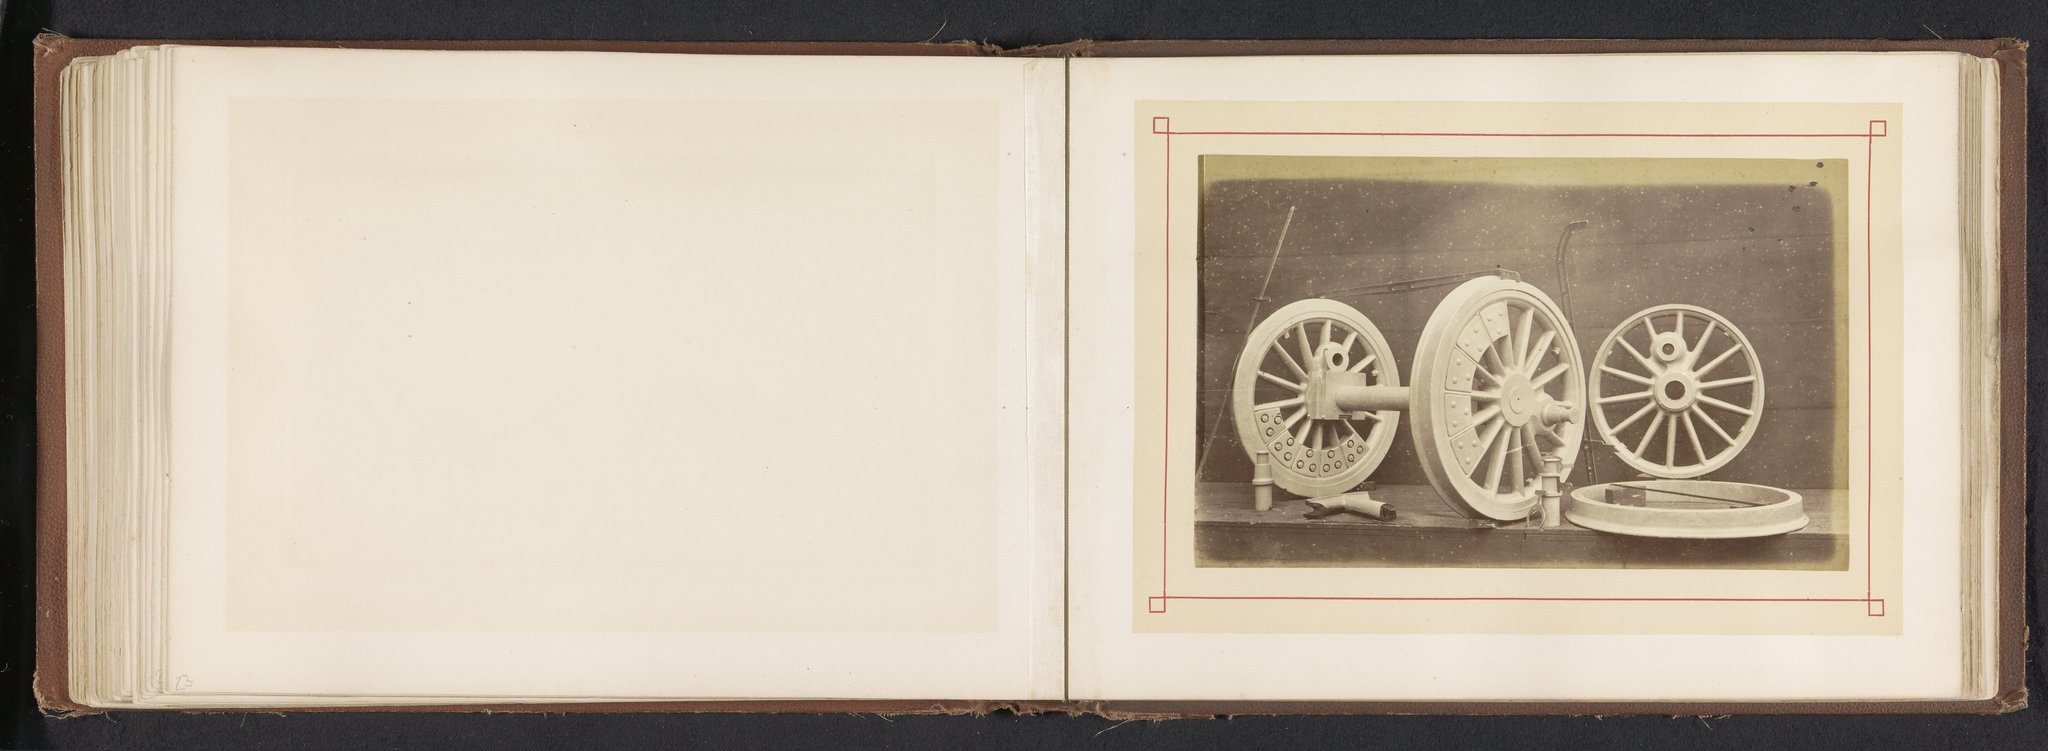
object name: photograph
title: Raderen van een stoomlocomotief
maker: george gardner rockwood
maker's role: fotograaf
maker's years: 1832-1911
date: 1861-1871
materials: photographic support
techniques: albumen print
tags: steam locomotive